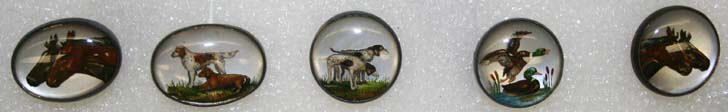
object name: button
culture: british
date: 1900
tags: birds,dogs,horses